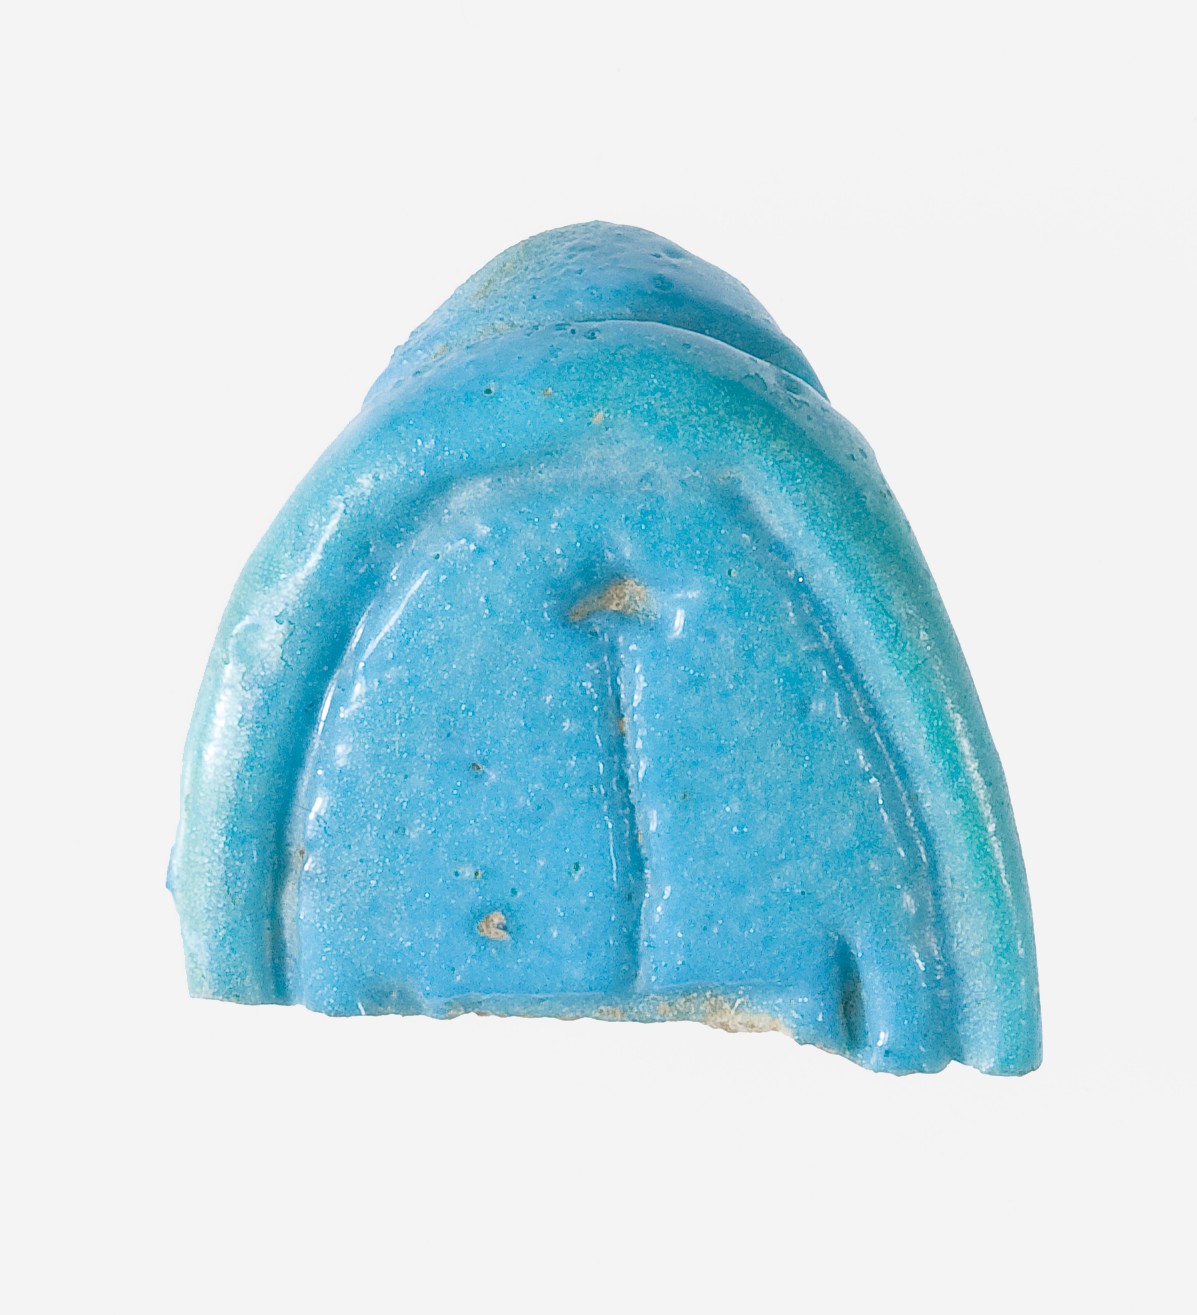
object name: ring fragment, ankh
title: Ring Fragment with ankh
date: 1390-1352 BCE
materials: faience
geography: egypt